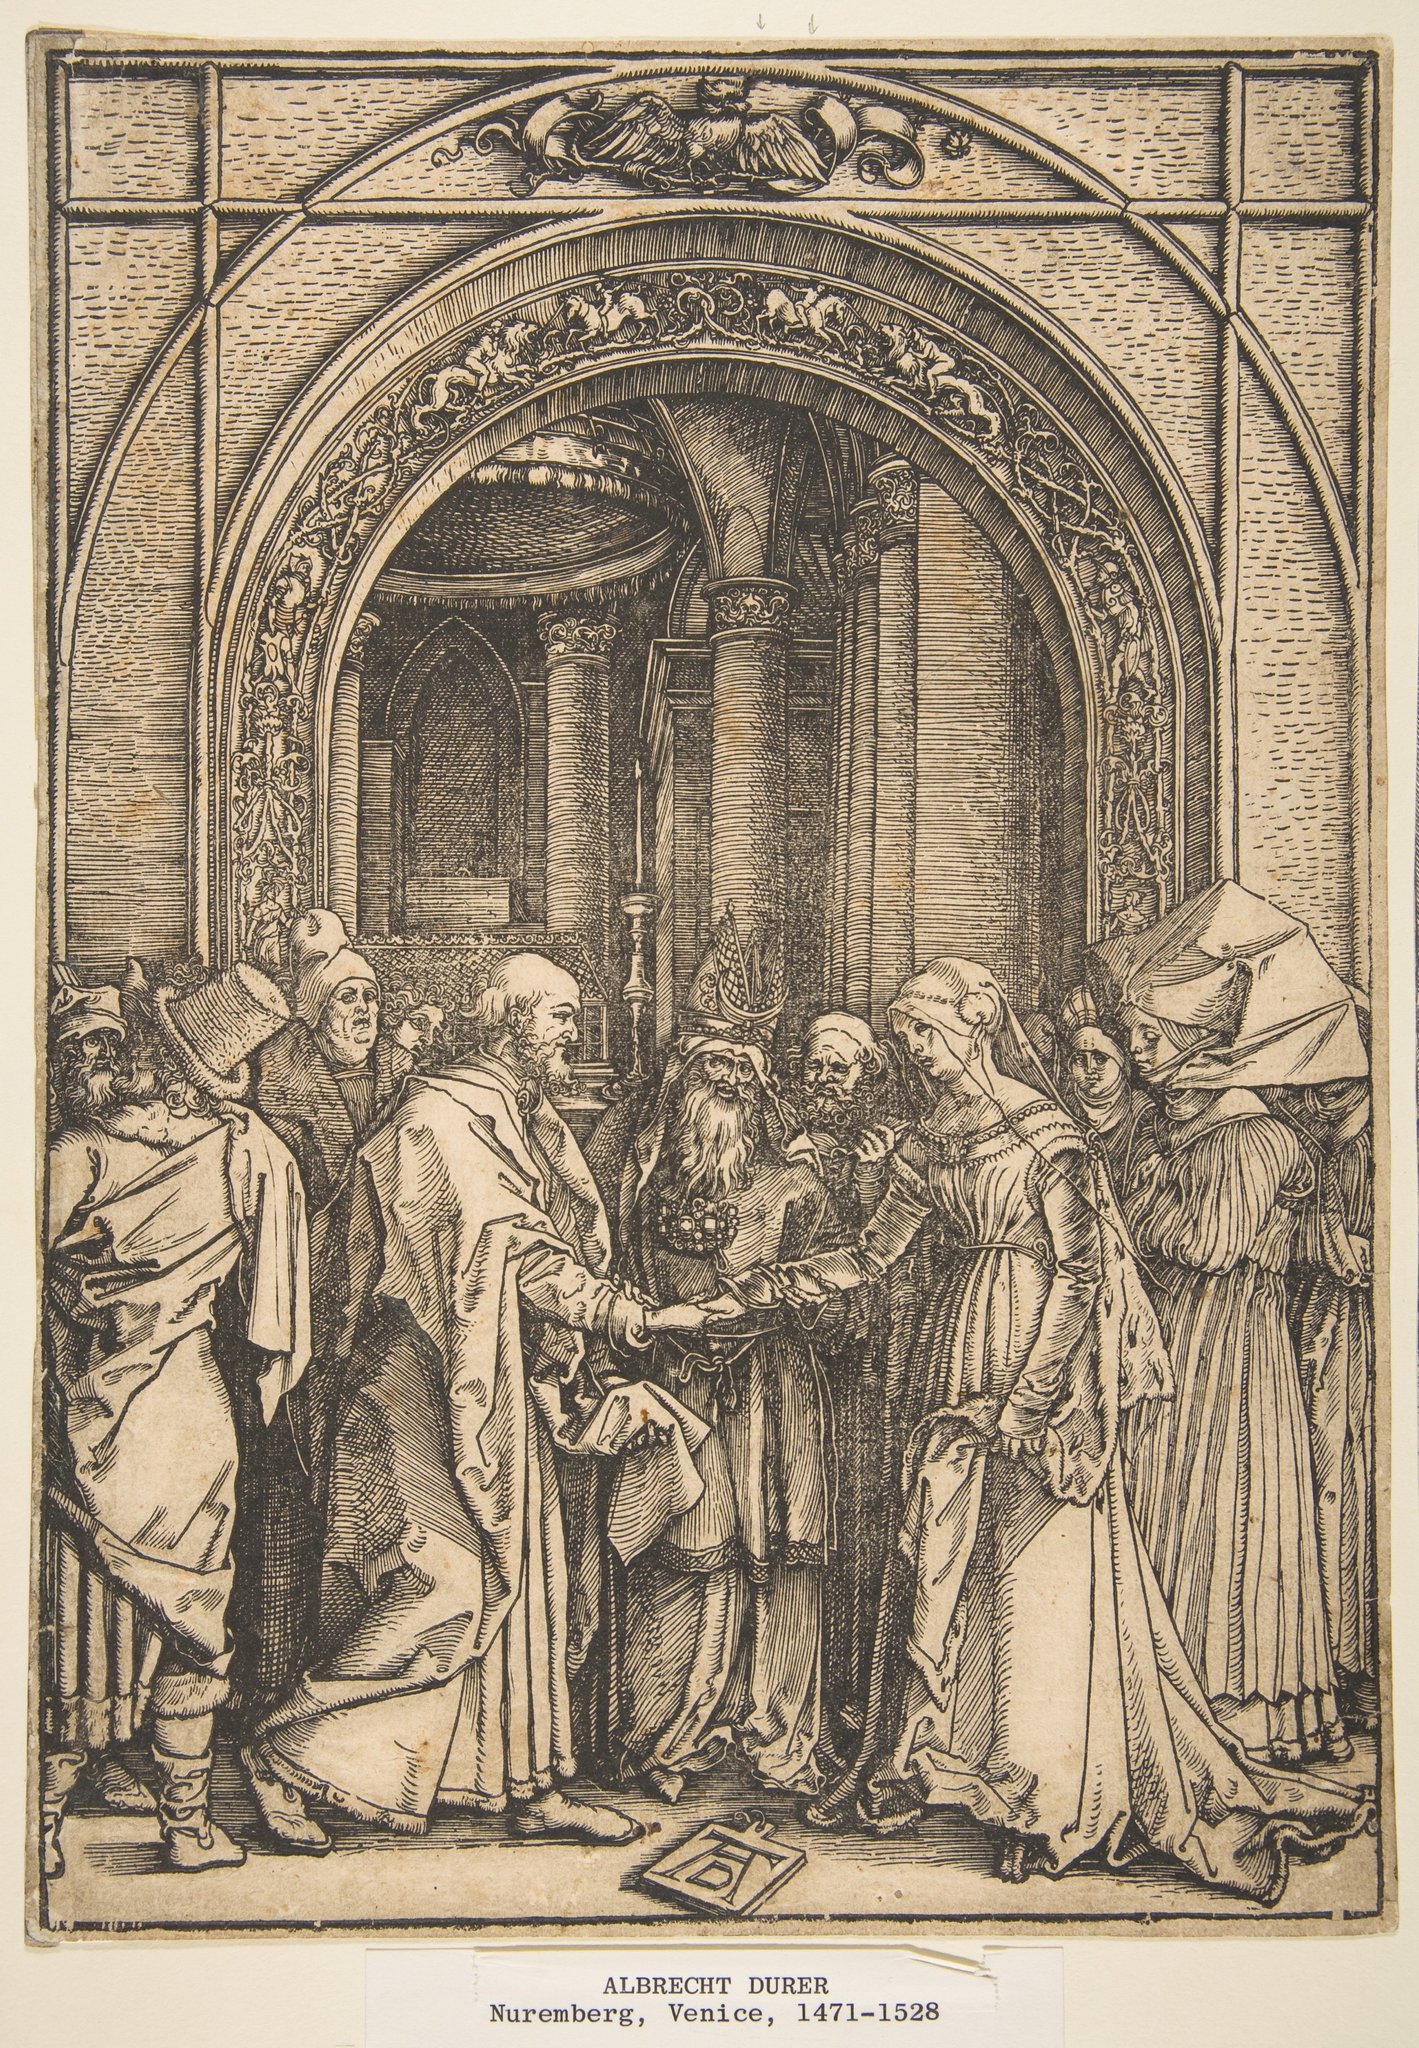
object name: print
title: The Betrothal of the Virgin, from "The Life of the Virgin"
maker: albrecht dürer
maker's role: artist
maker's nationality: german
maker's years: 1471-1528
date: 1503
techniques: woodcut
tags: men,women,virgin mary